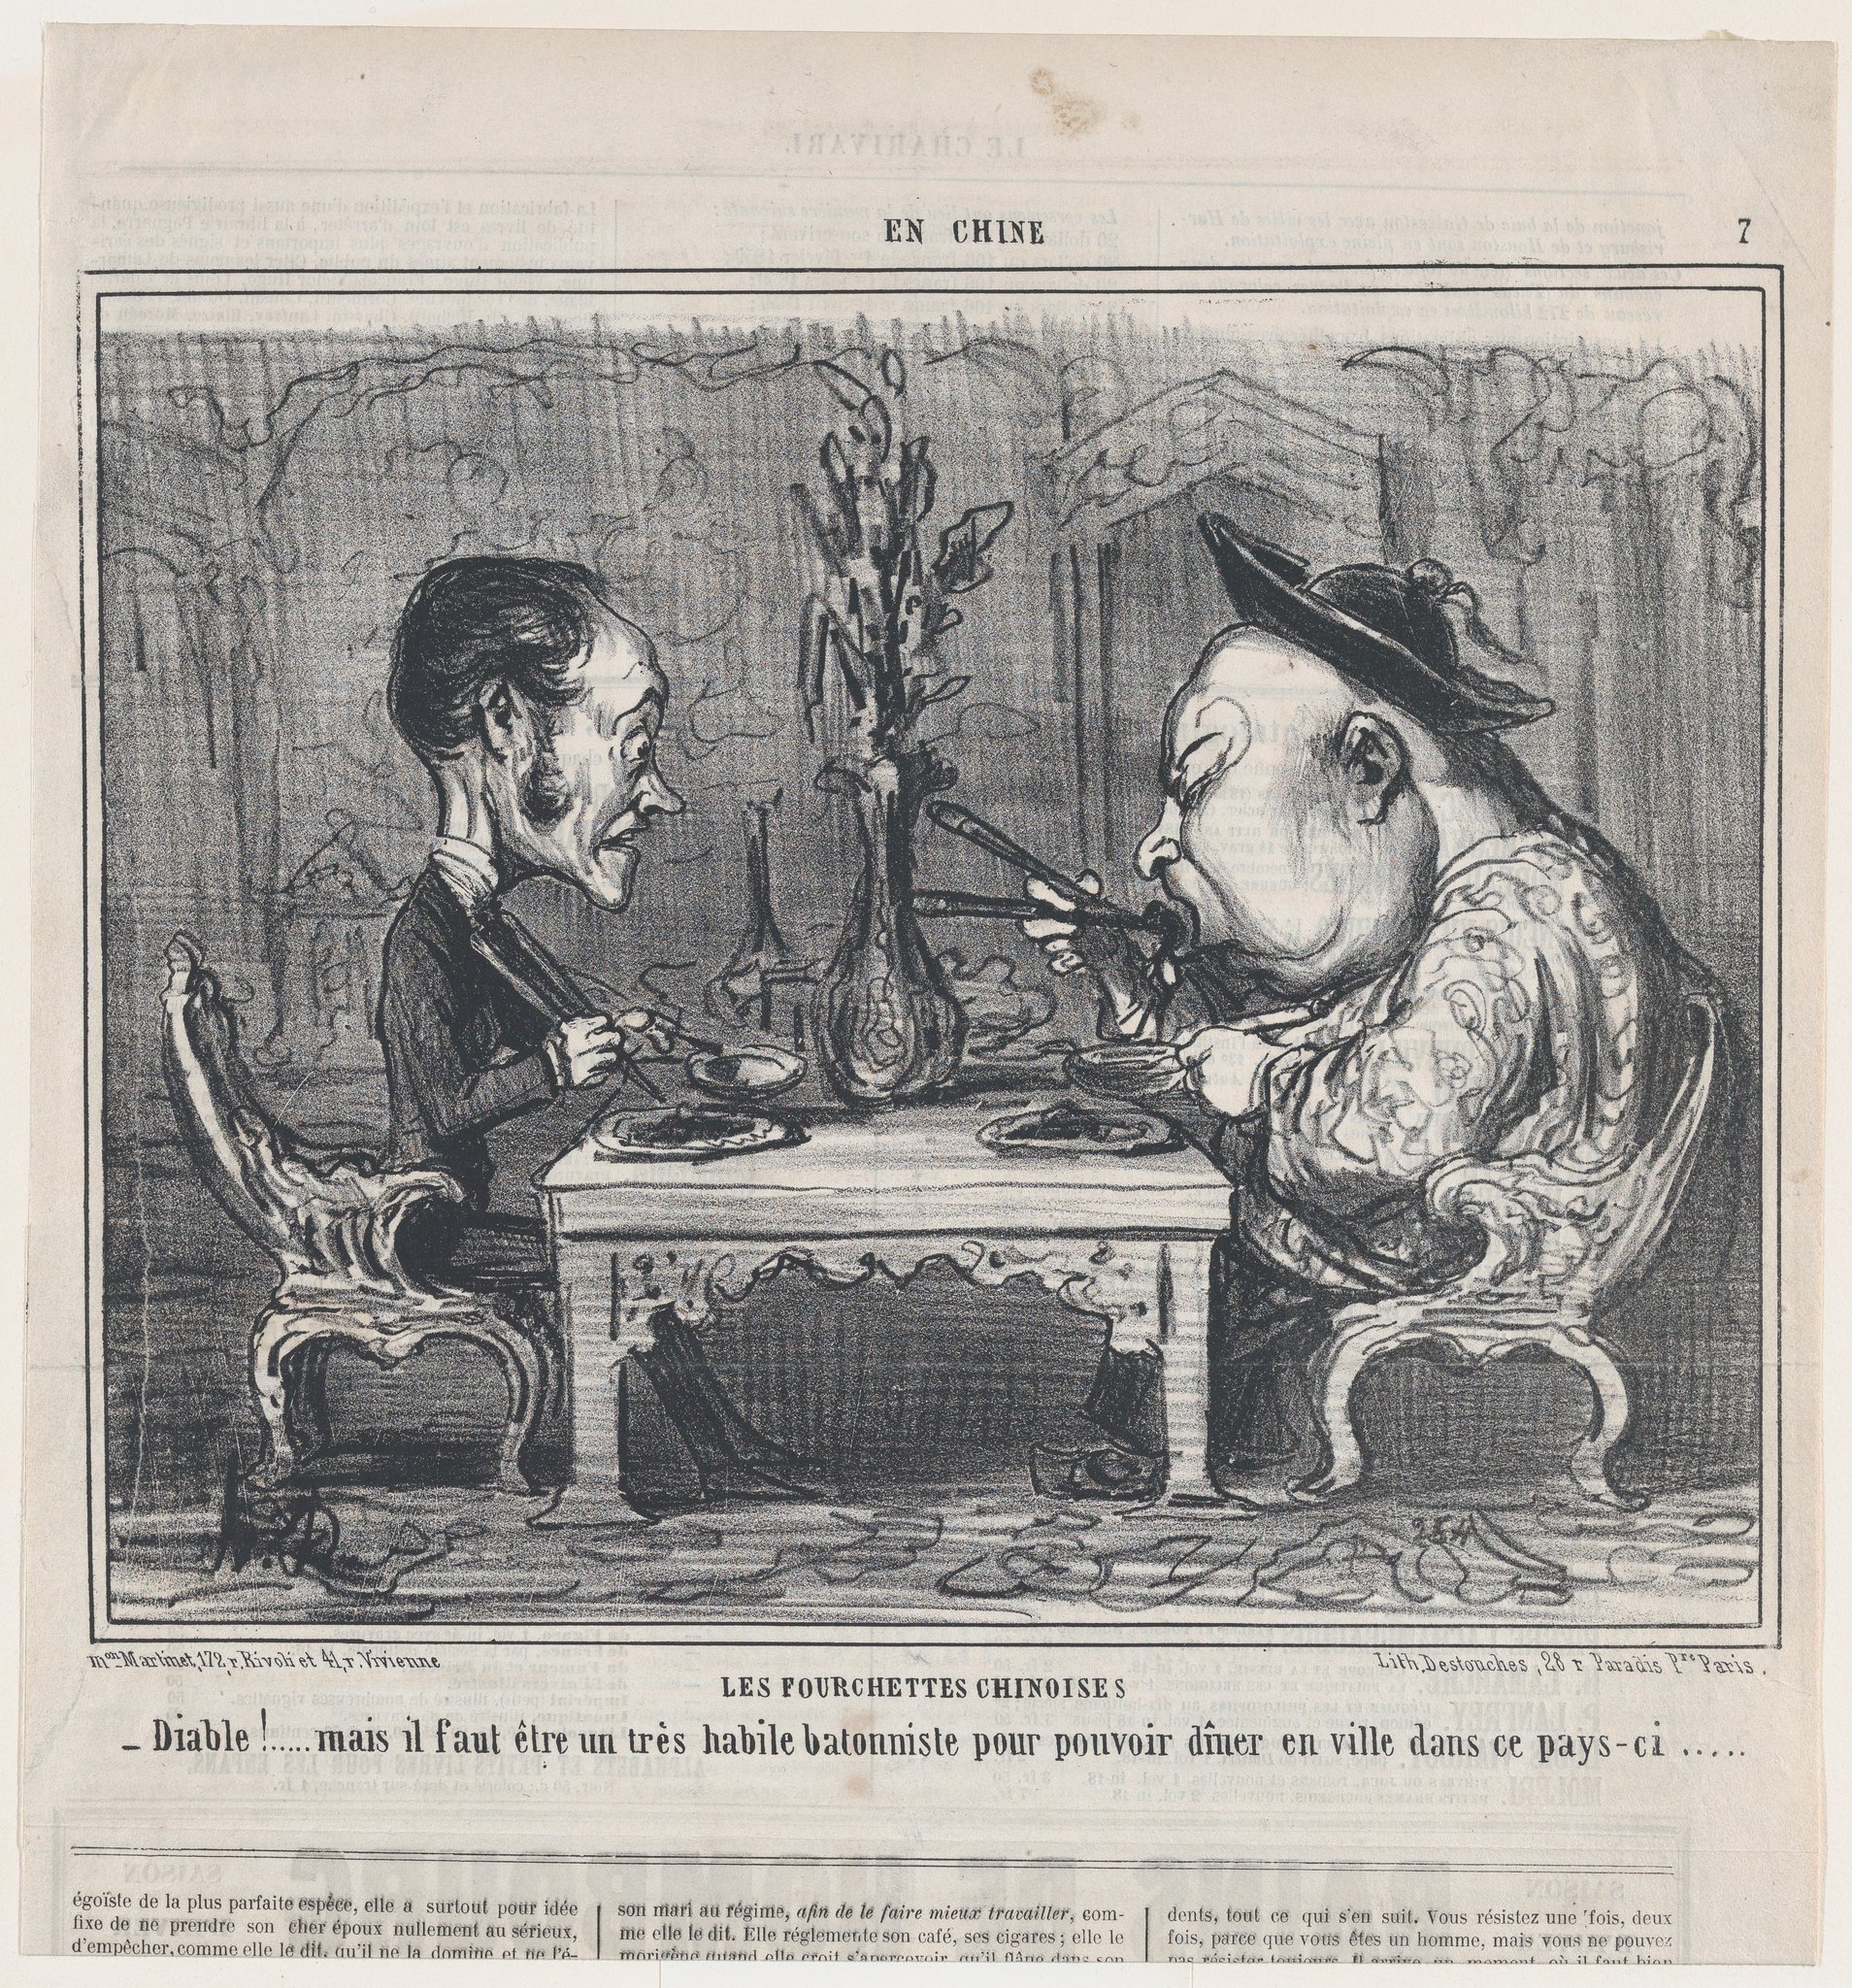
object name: print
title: Les Fourchettes Chinoises, from En Chine, published in Le Charivari, December 27, 1858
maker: honoré daumier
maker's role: artist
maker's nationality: french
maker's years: 1808-1879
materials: paper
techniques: lithograph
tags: satire,men